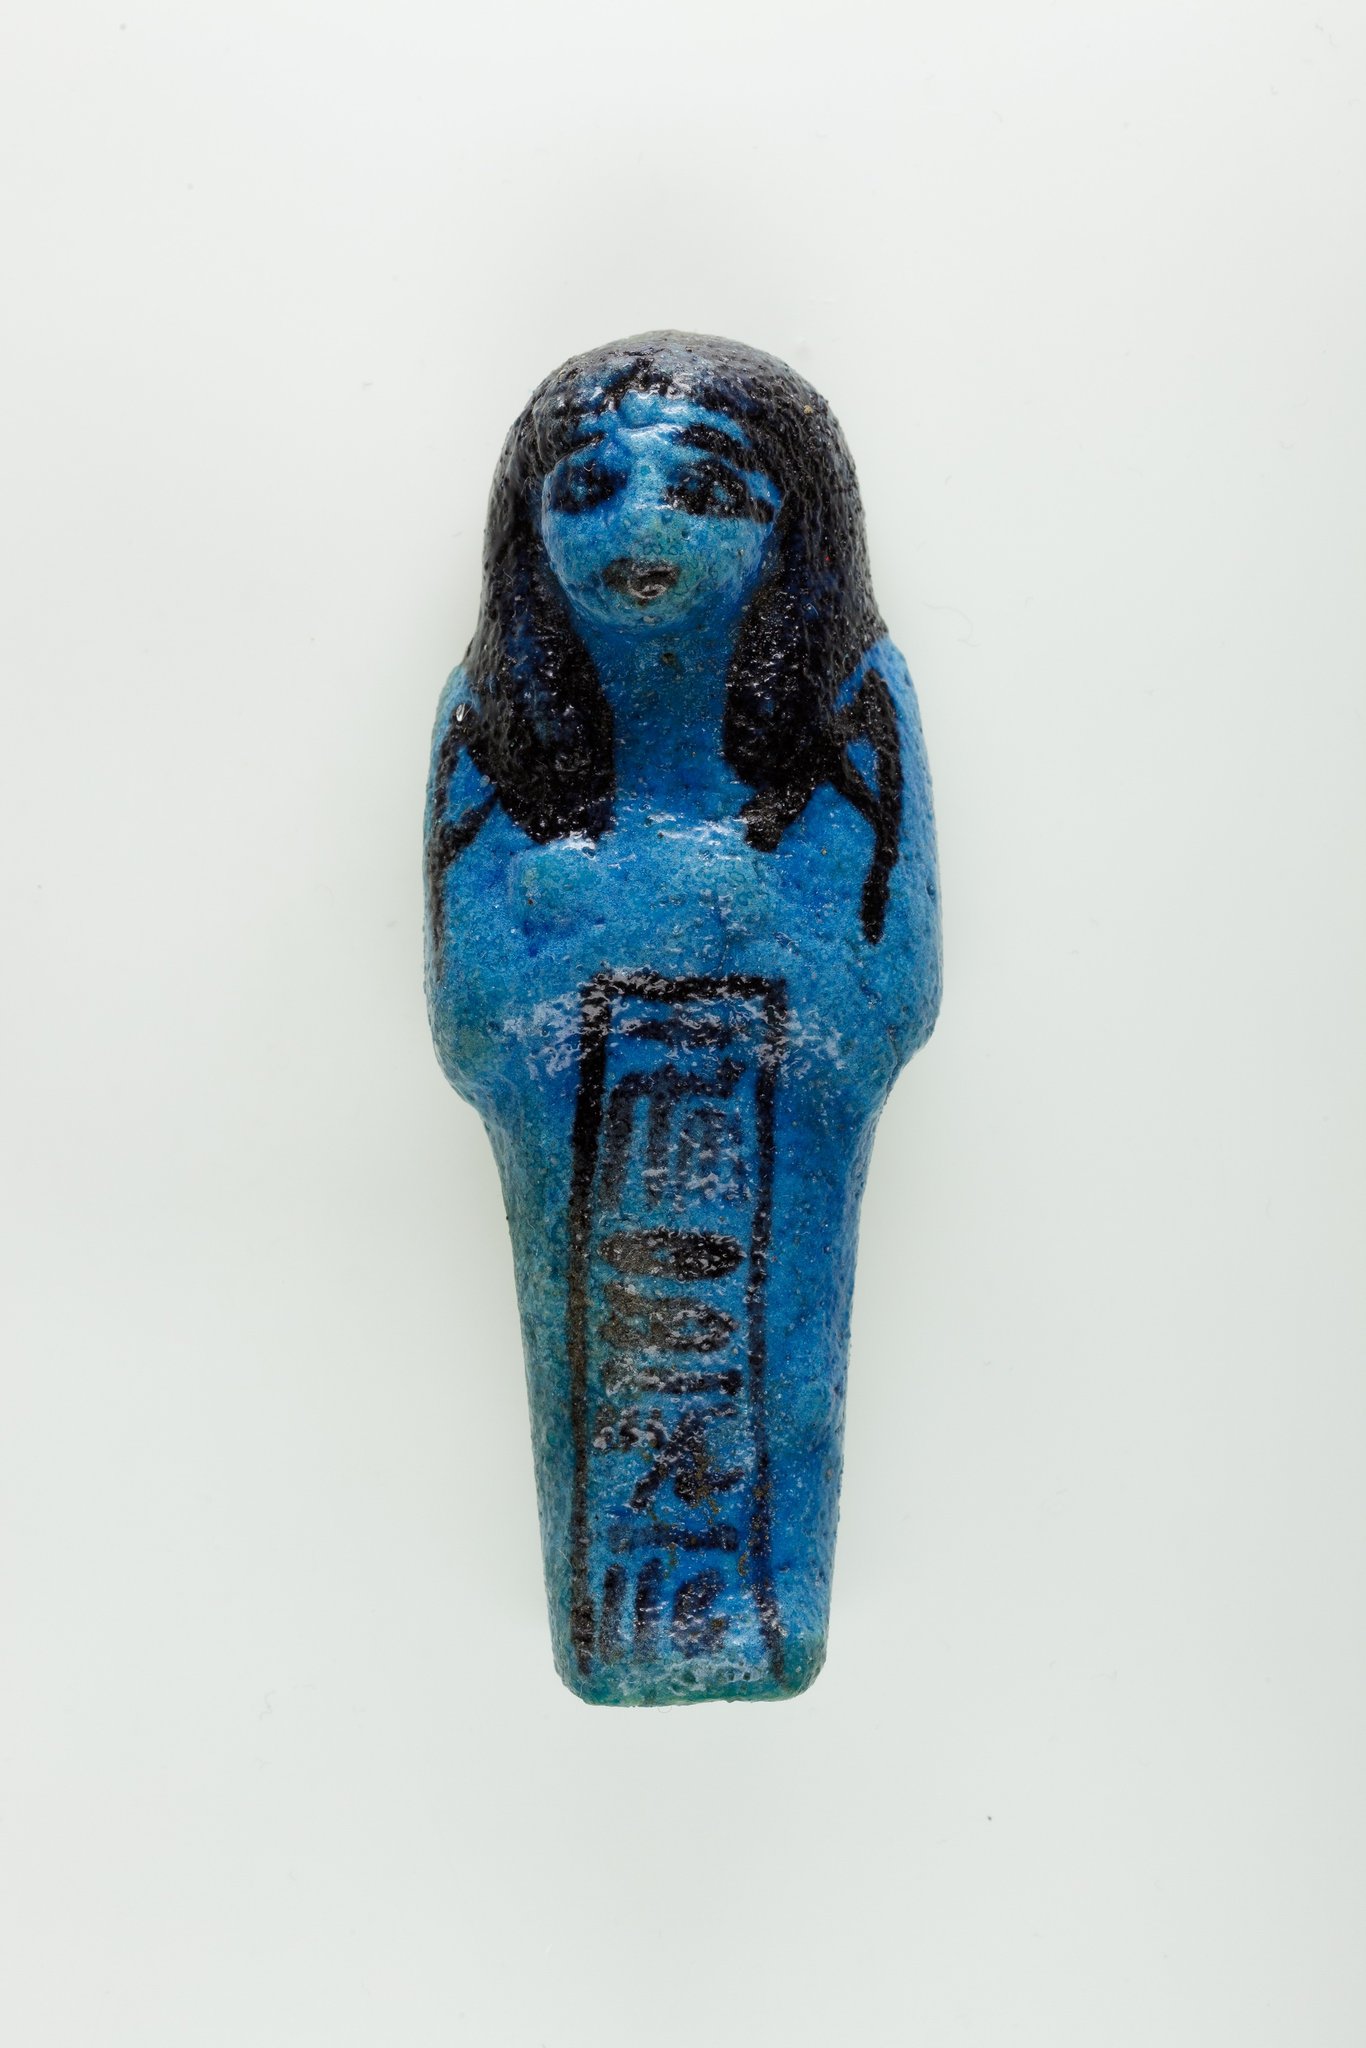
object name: shabti, worker, nauny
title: Worker Shabti of Nauny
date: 1050 BCE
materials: faience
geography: egypt